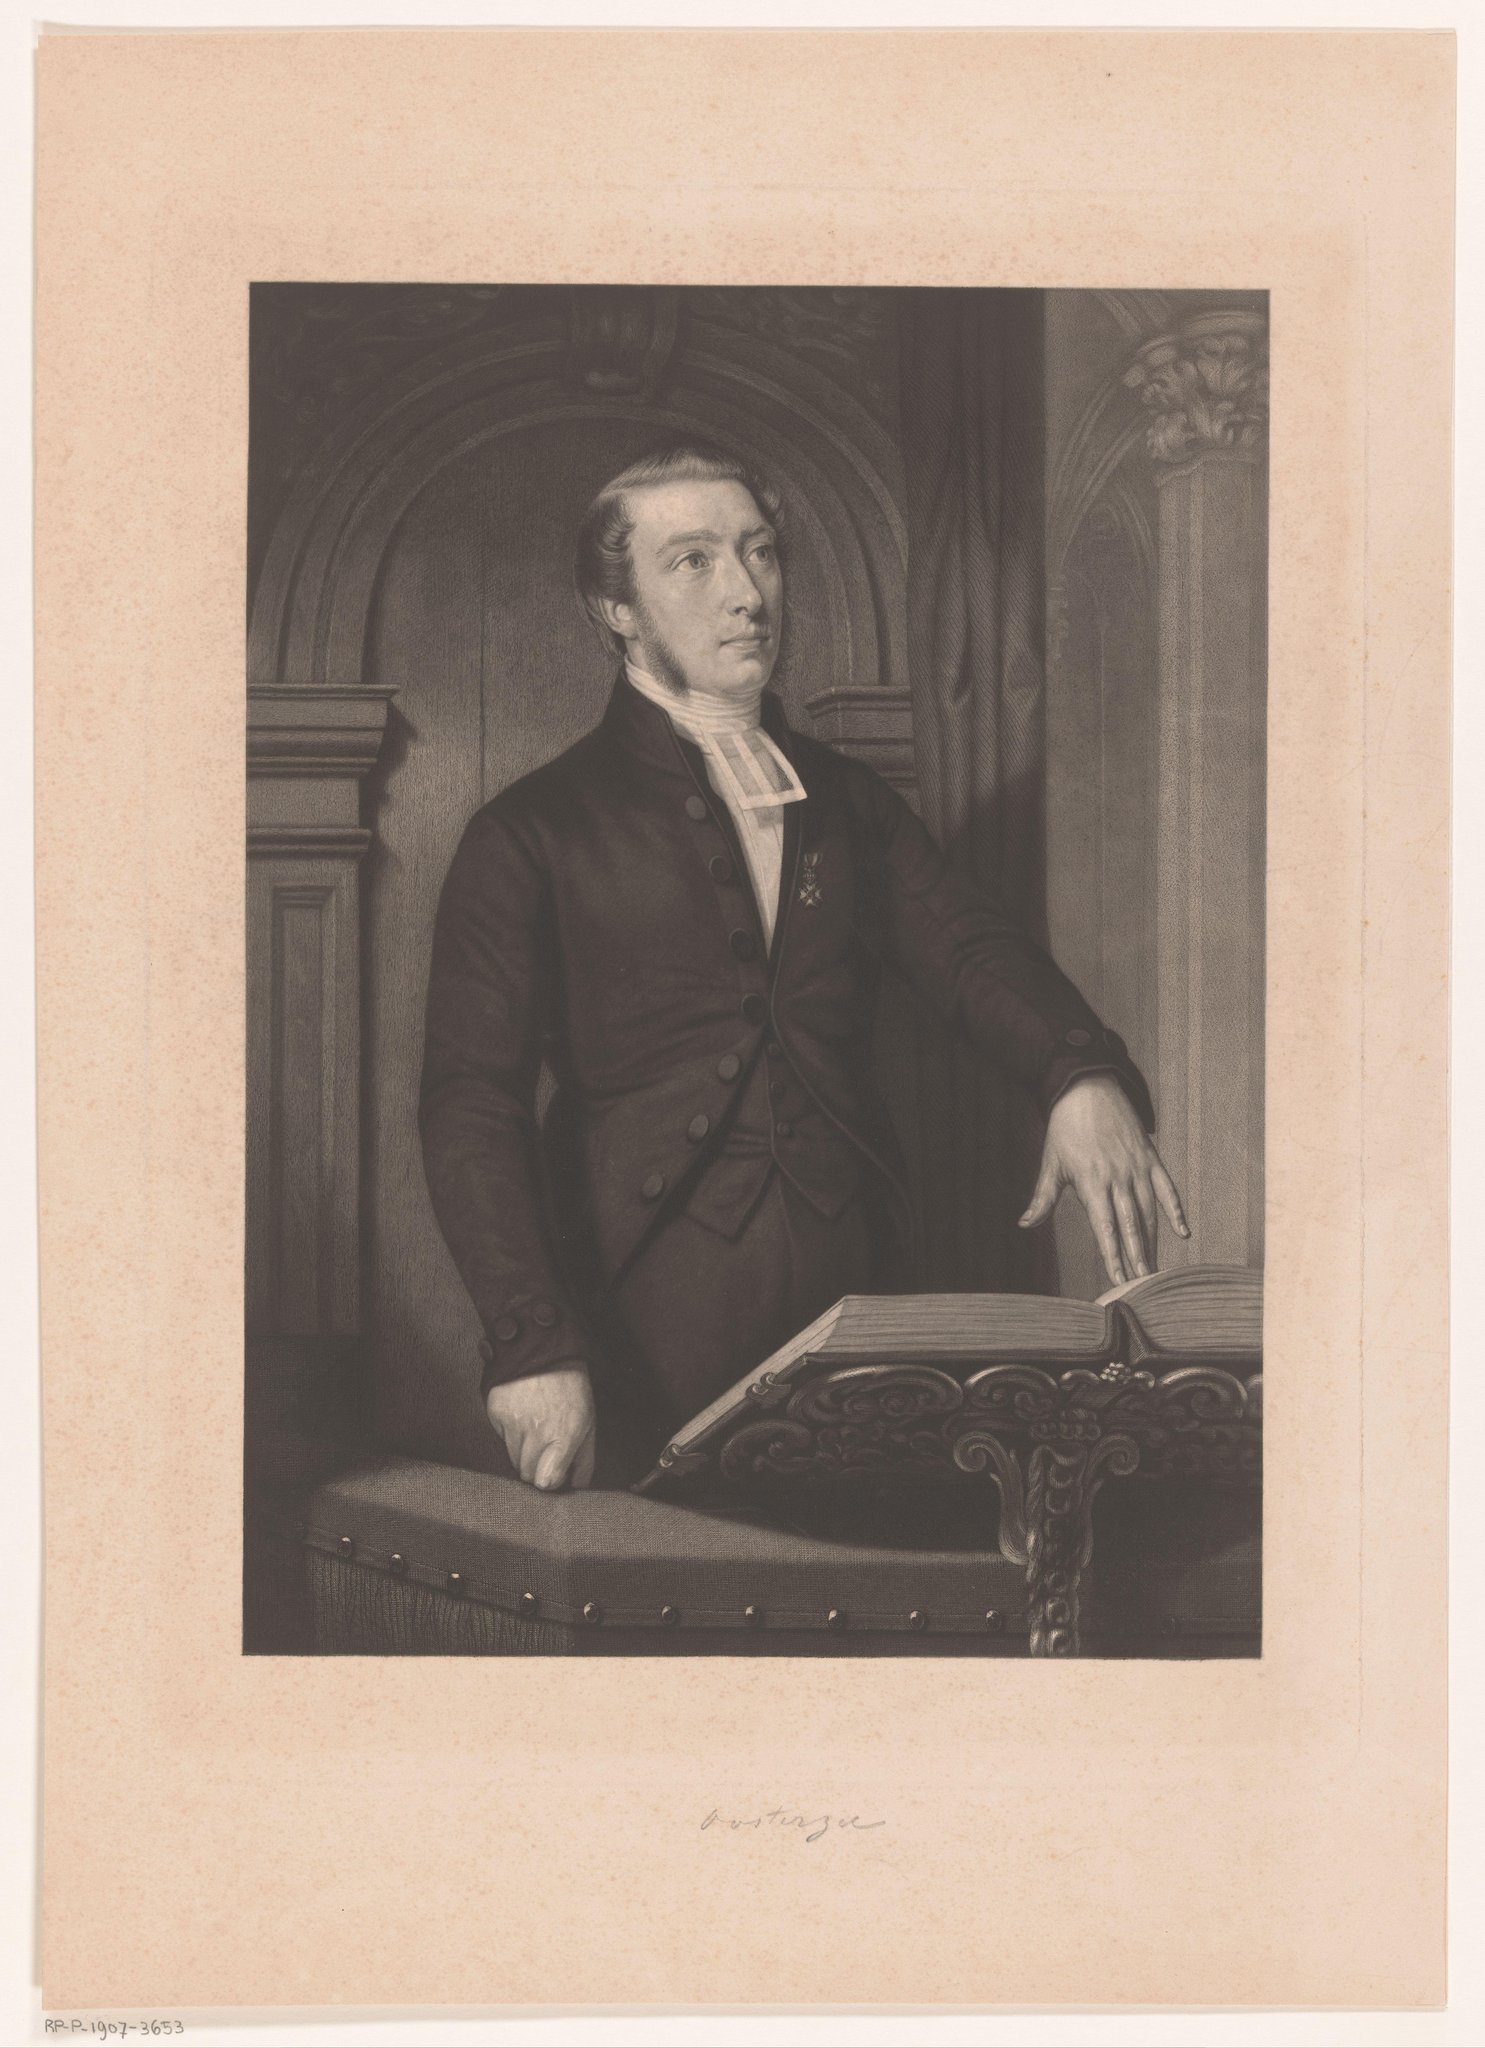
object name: print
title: Portret van Johannes Jacobus van Oosterzee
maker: jean baptiste alfred cornilliet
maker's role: print maker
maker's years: 1807-1895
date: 1817-1895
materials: paper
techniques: etching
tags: rotterdam, johannes jacobus van oosterzee, theologian, historical persons, functionaries and dignitaries ~ protestant churches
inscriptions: collector's mark: Lugt 2228